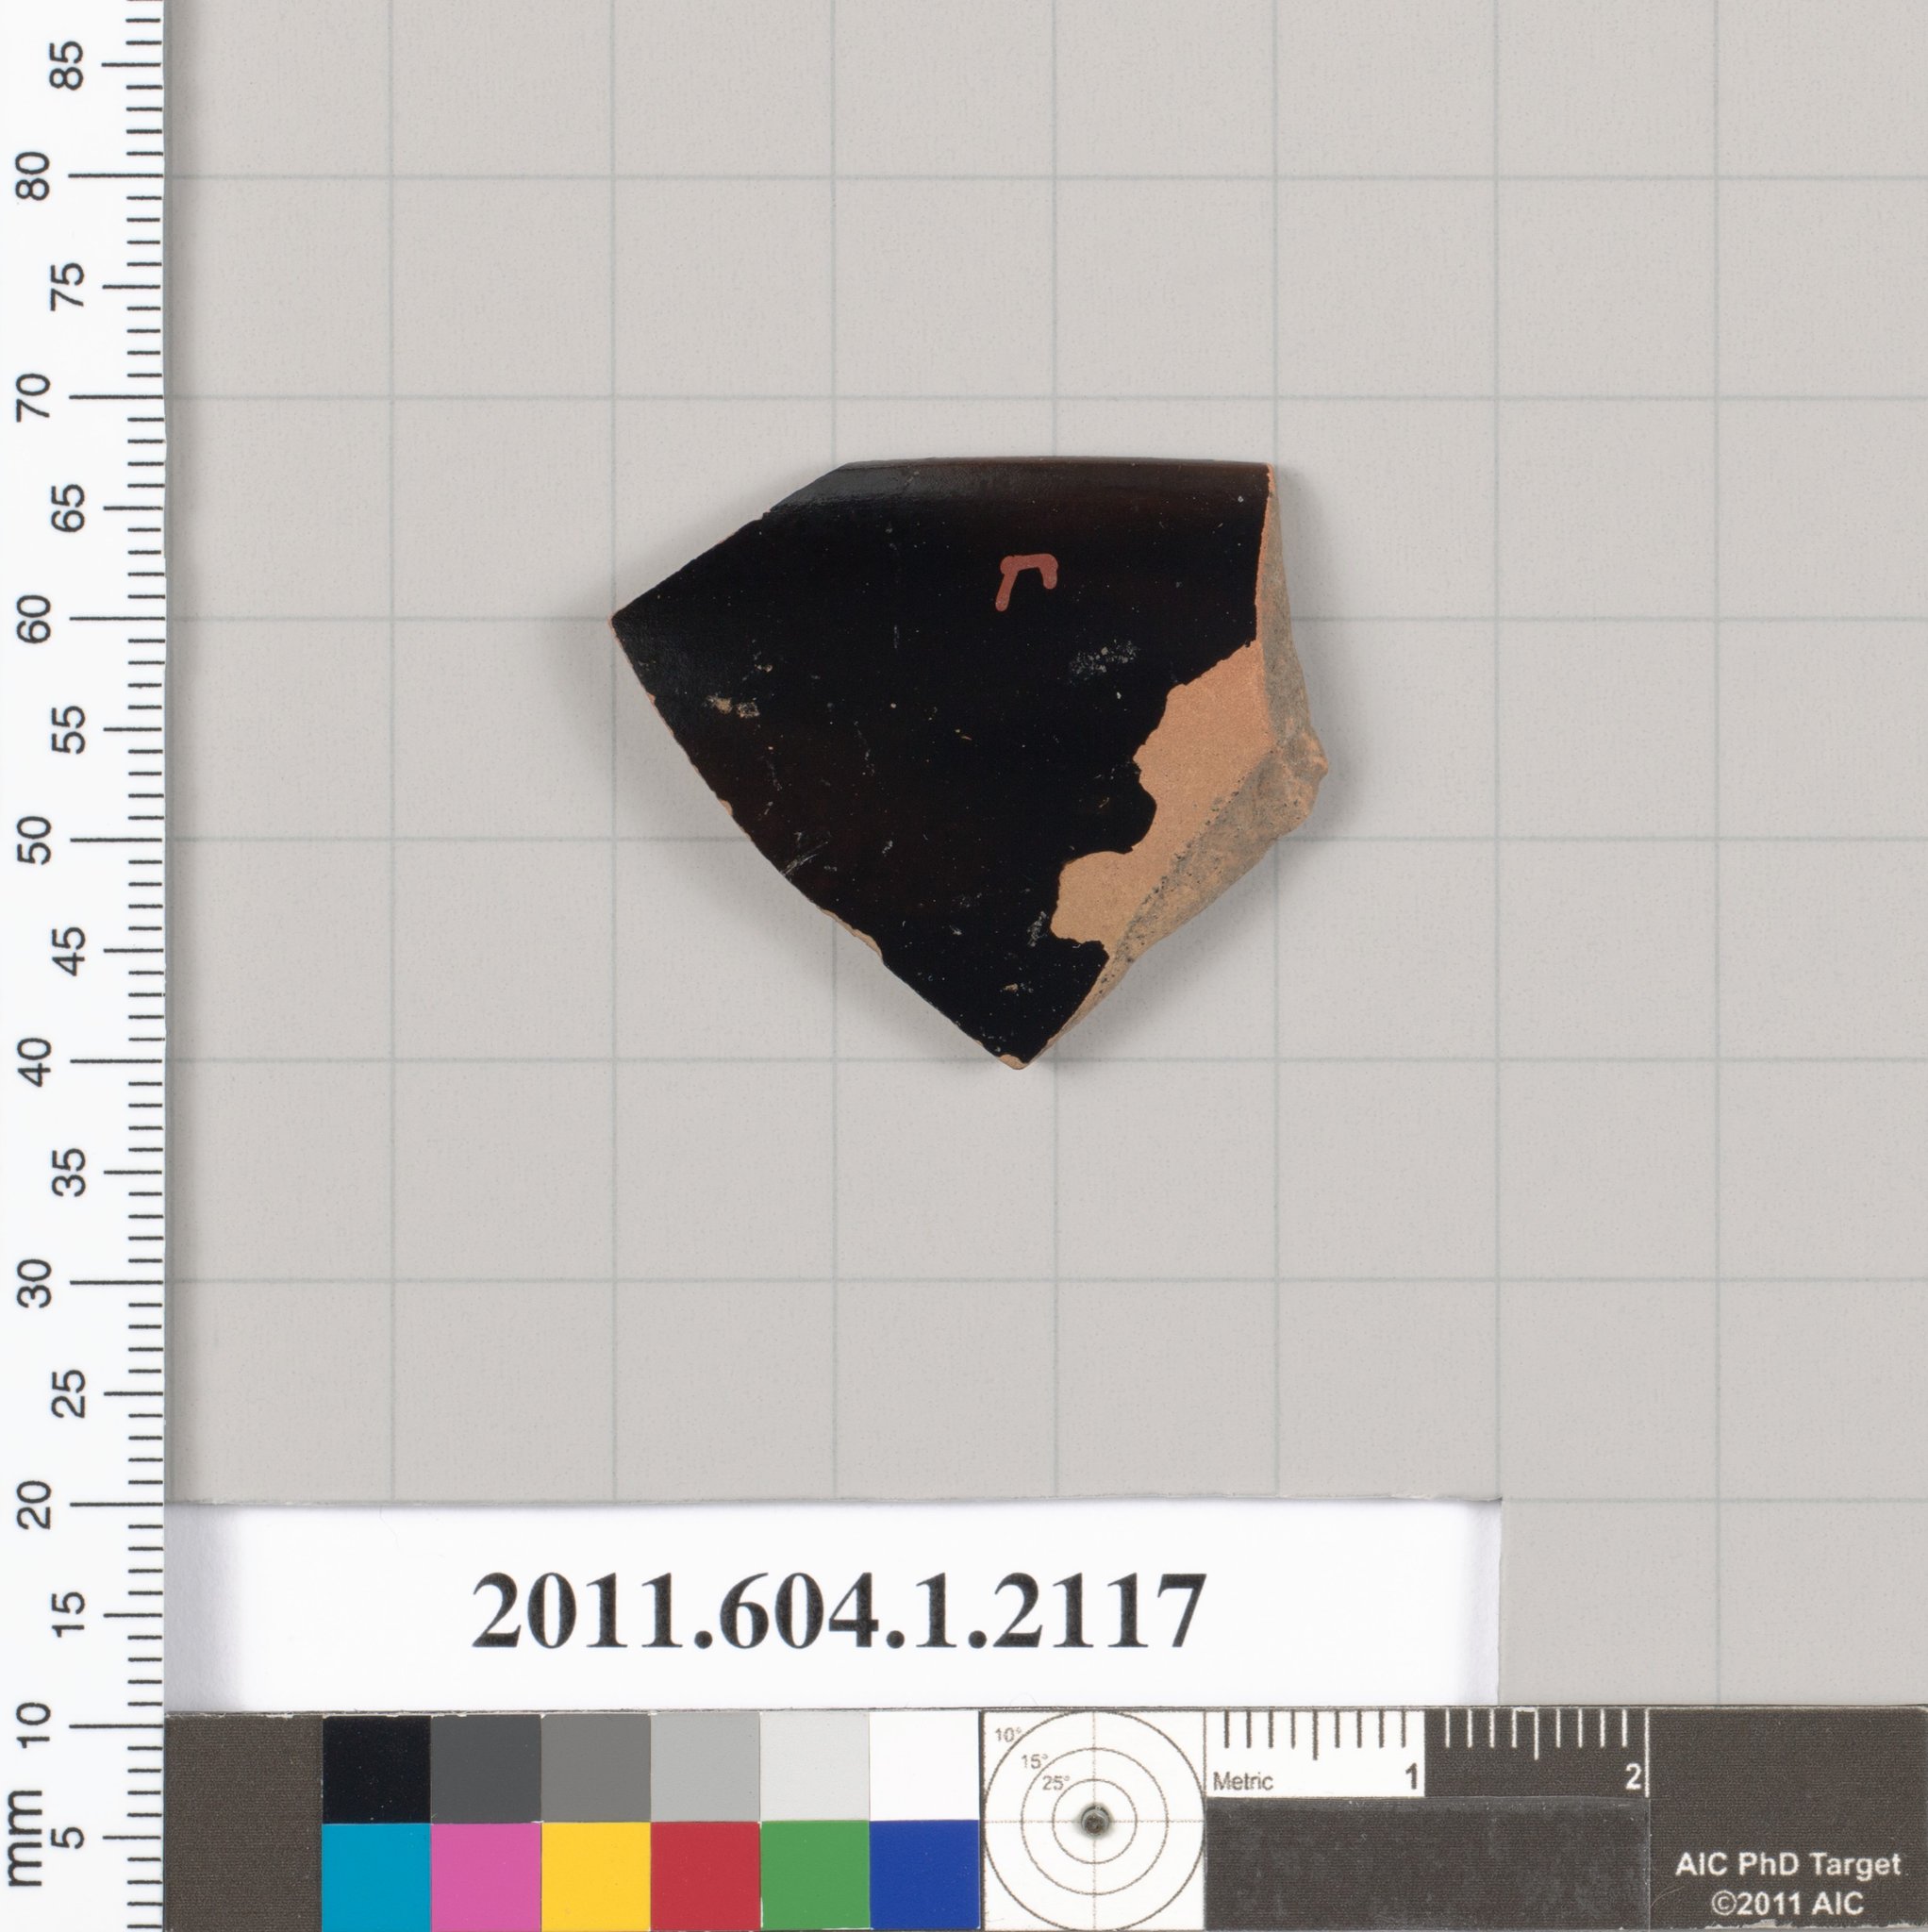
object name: kylix fragment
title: Terracotta rim fragment of a kylix (drinking cup)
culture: greek, attic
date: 500-401 BCE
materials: terracotta